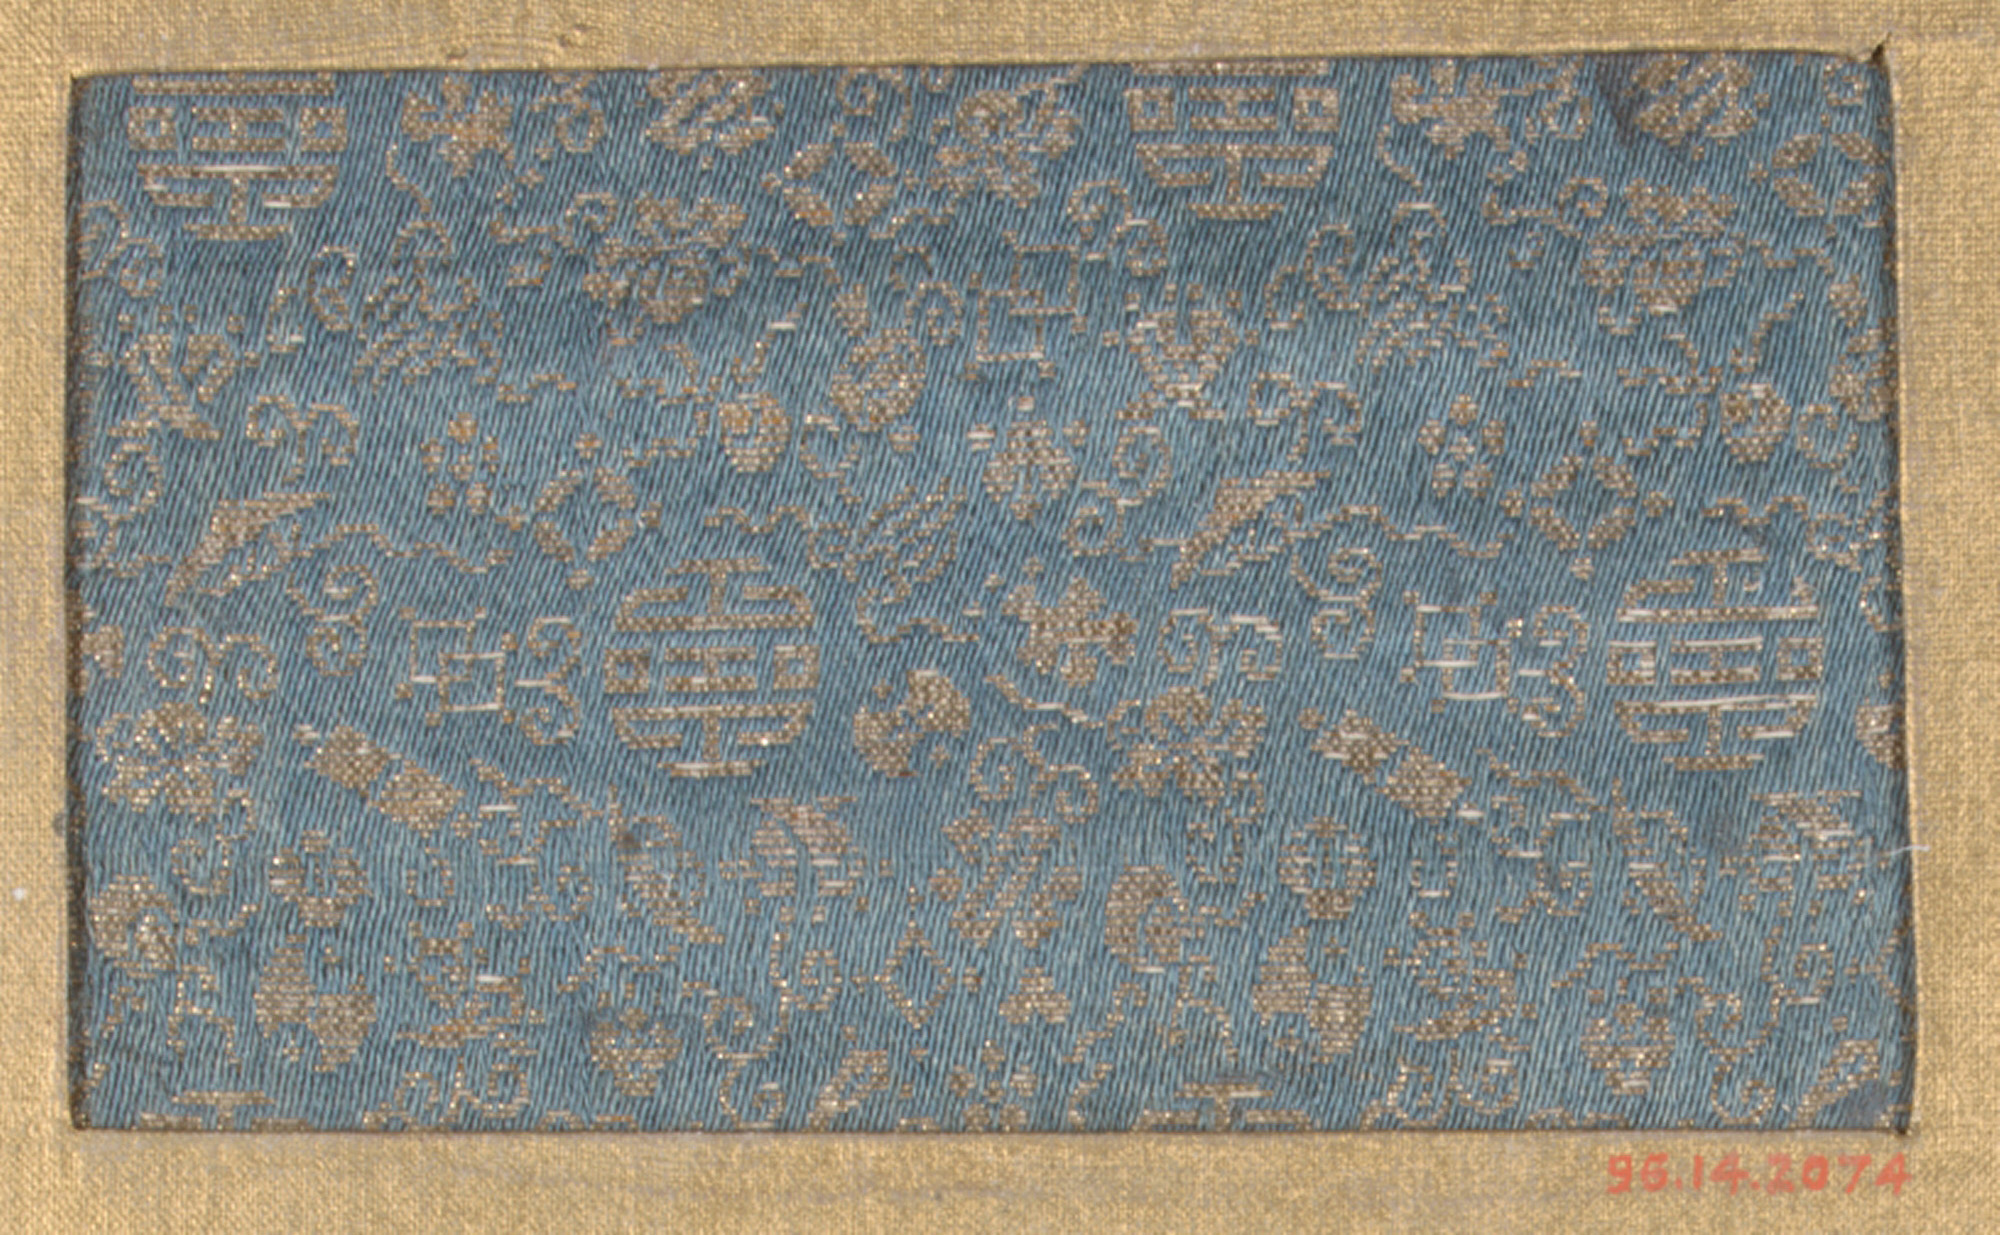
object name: piece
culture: japanese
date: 1701-1900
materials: silk